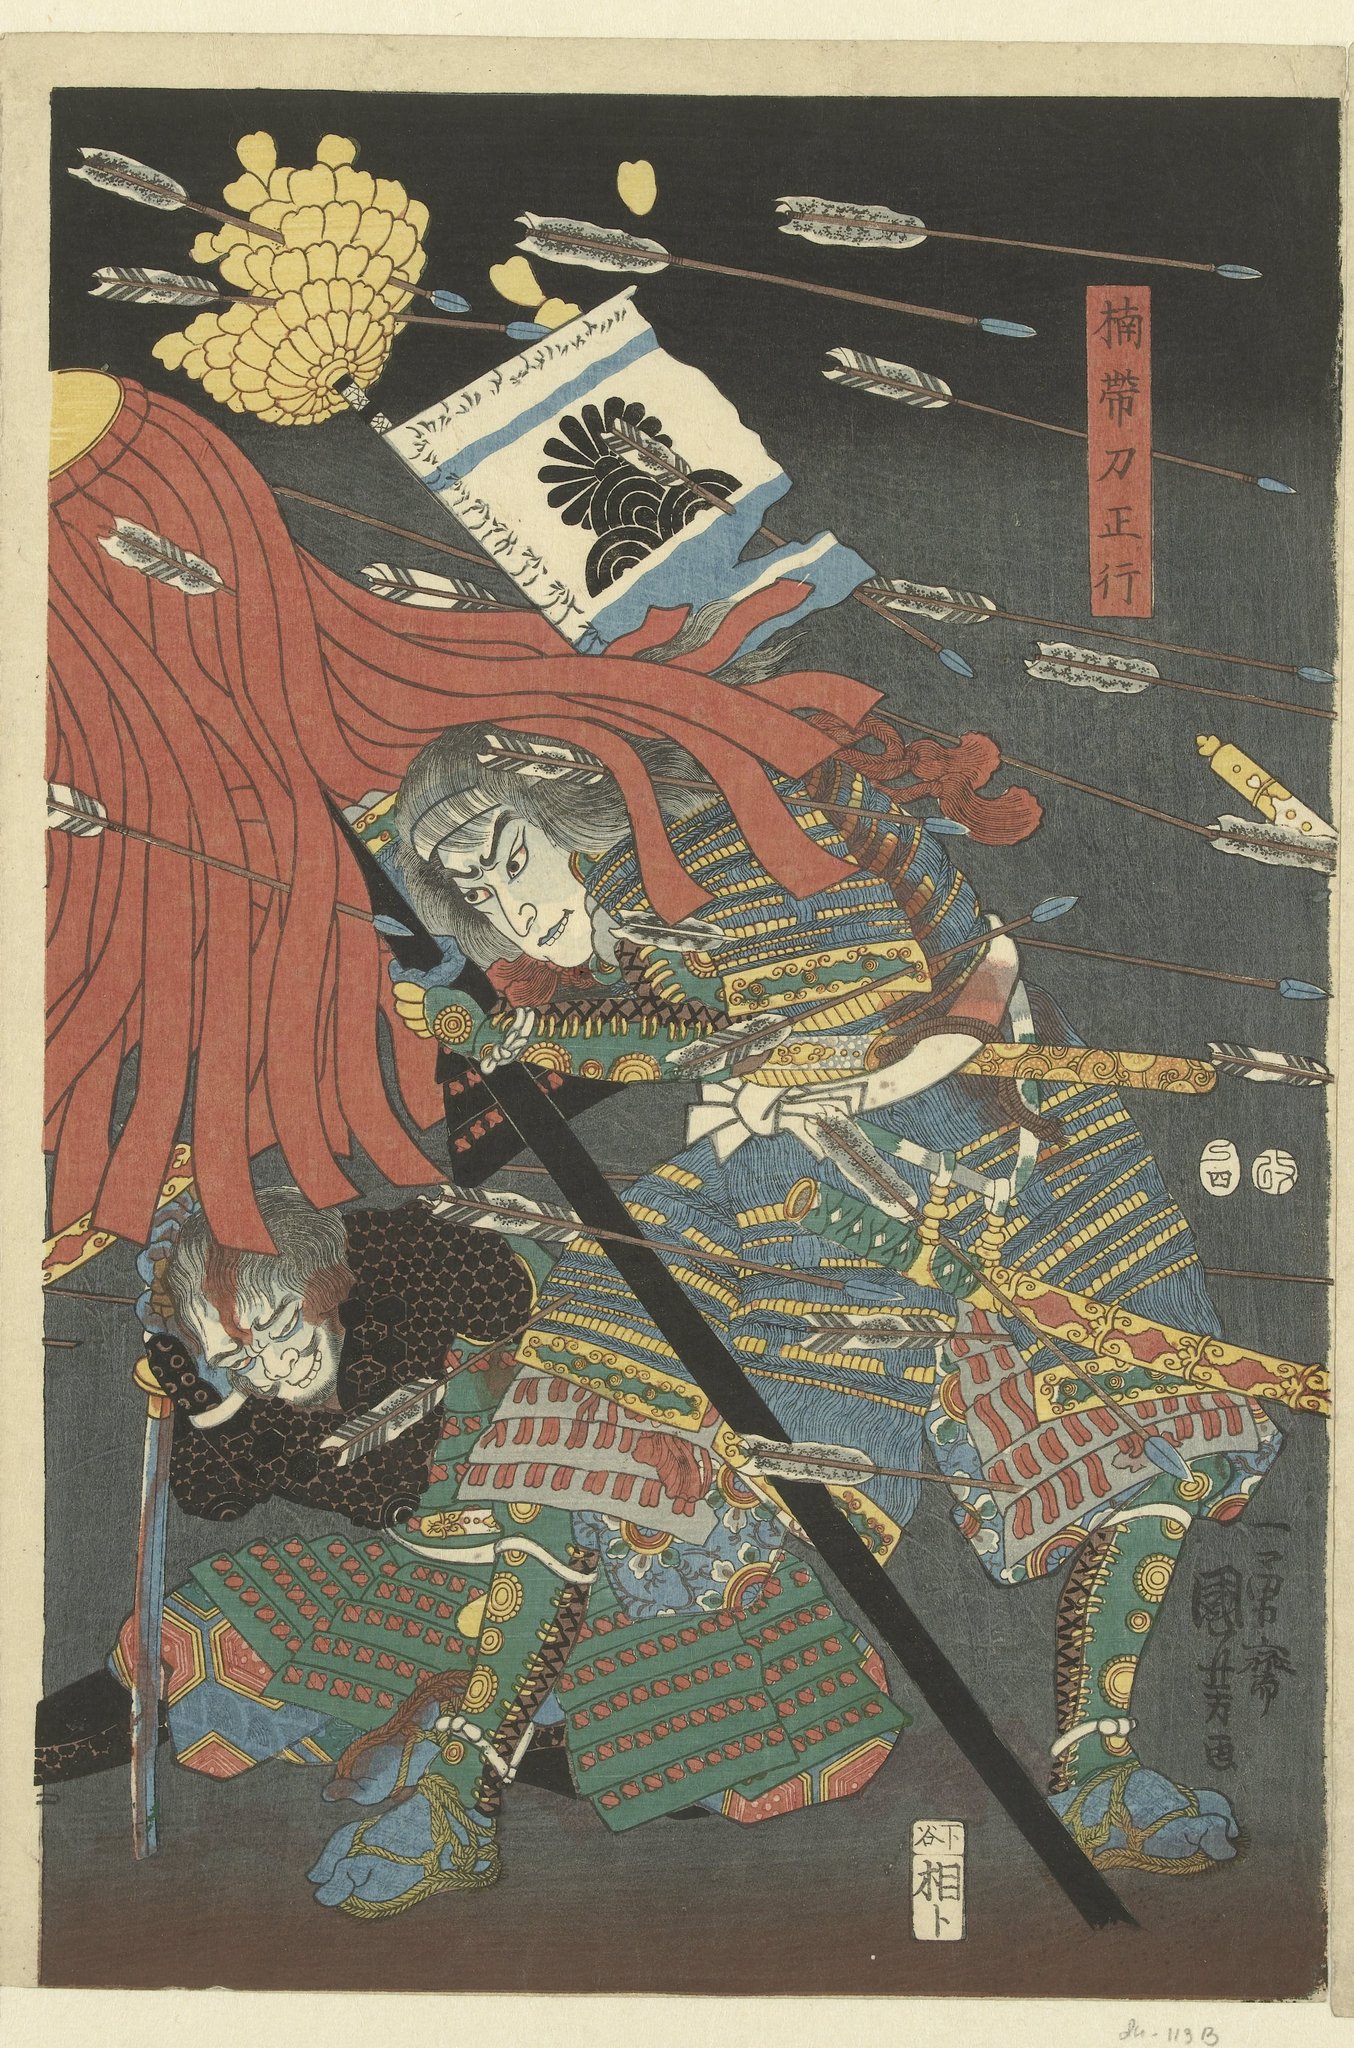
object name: print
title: Shijonawate nite Nanke no eiyu taiteki o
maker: utagawa kuniyoshi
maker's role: draughtsman, print maker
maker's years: 1798-1861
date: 1847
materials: paper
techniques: woodcut, nishiki e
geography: japan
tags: battle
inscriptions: collector's mark: Lugt 2228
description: Twee krijgers van de Kusunoki clan, één een groot vaandel vasthoudend, proberen stand te houden in een pijlenregen van de Ashikaga troepen te Shijonawate. Tweede blad van zesluik.